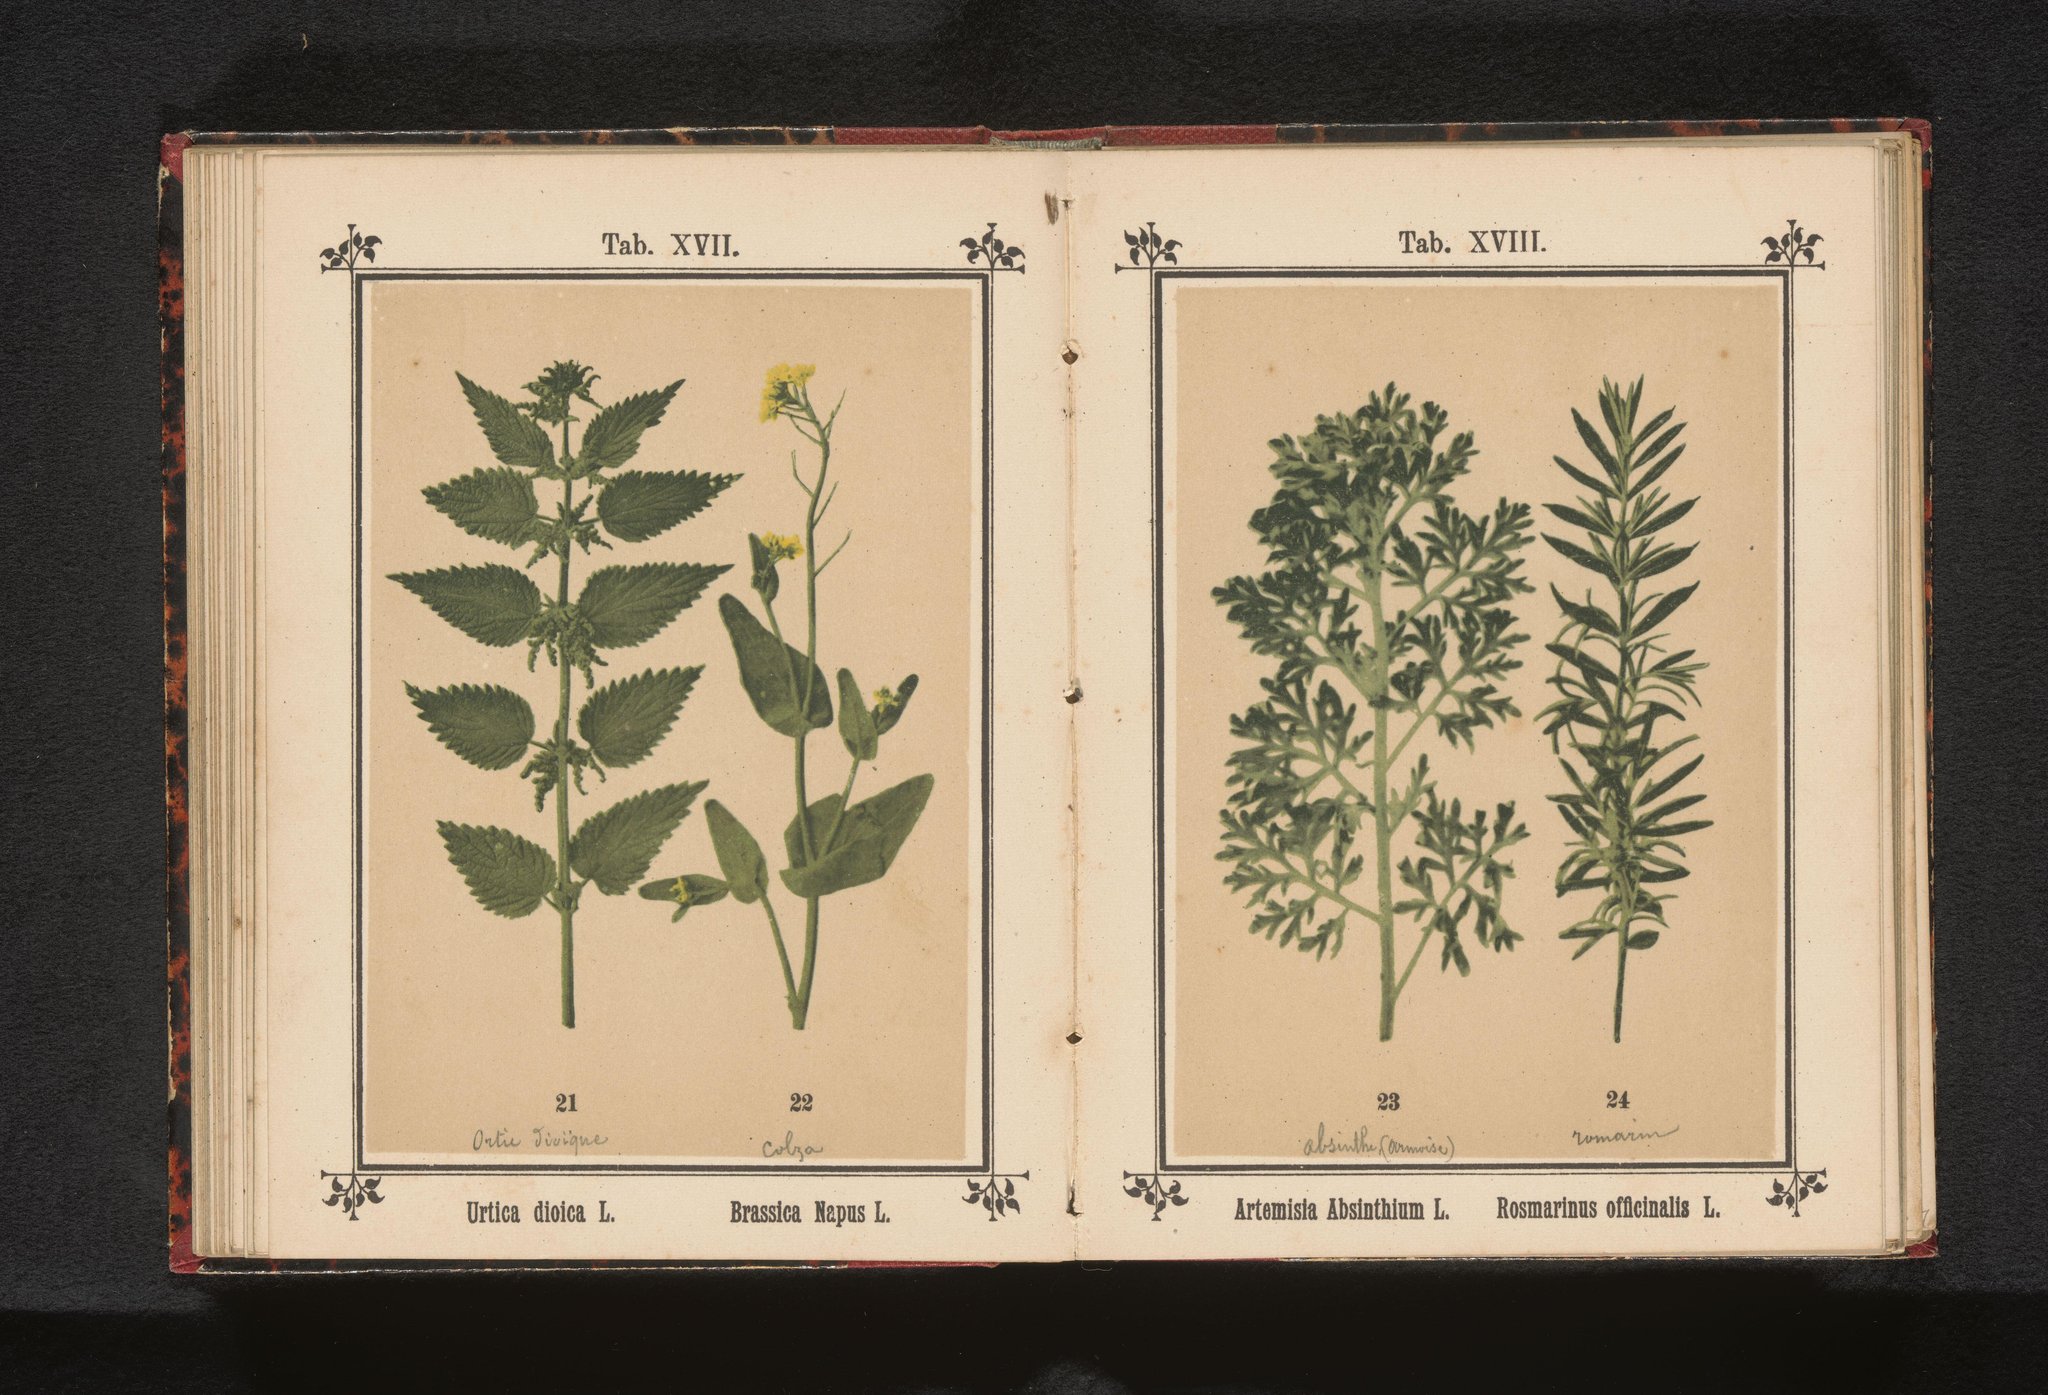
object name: photomechanical print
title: Artemista Absinthium L. Rosmarinus officinalis L.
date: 1884-1894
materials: paper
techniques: photograph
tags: plants and herbs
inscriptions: inscription: ‘absinthe(armoise) romain’, number: ‘Tab. XVIII.’